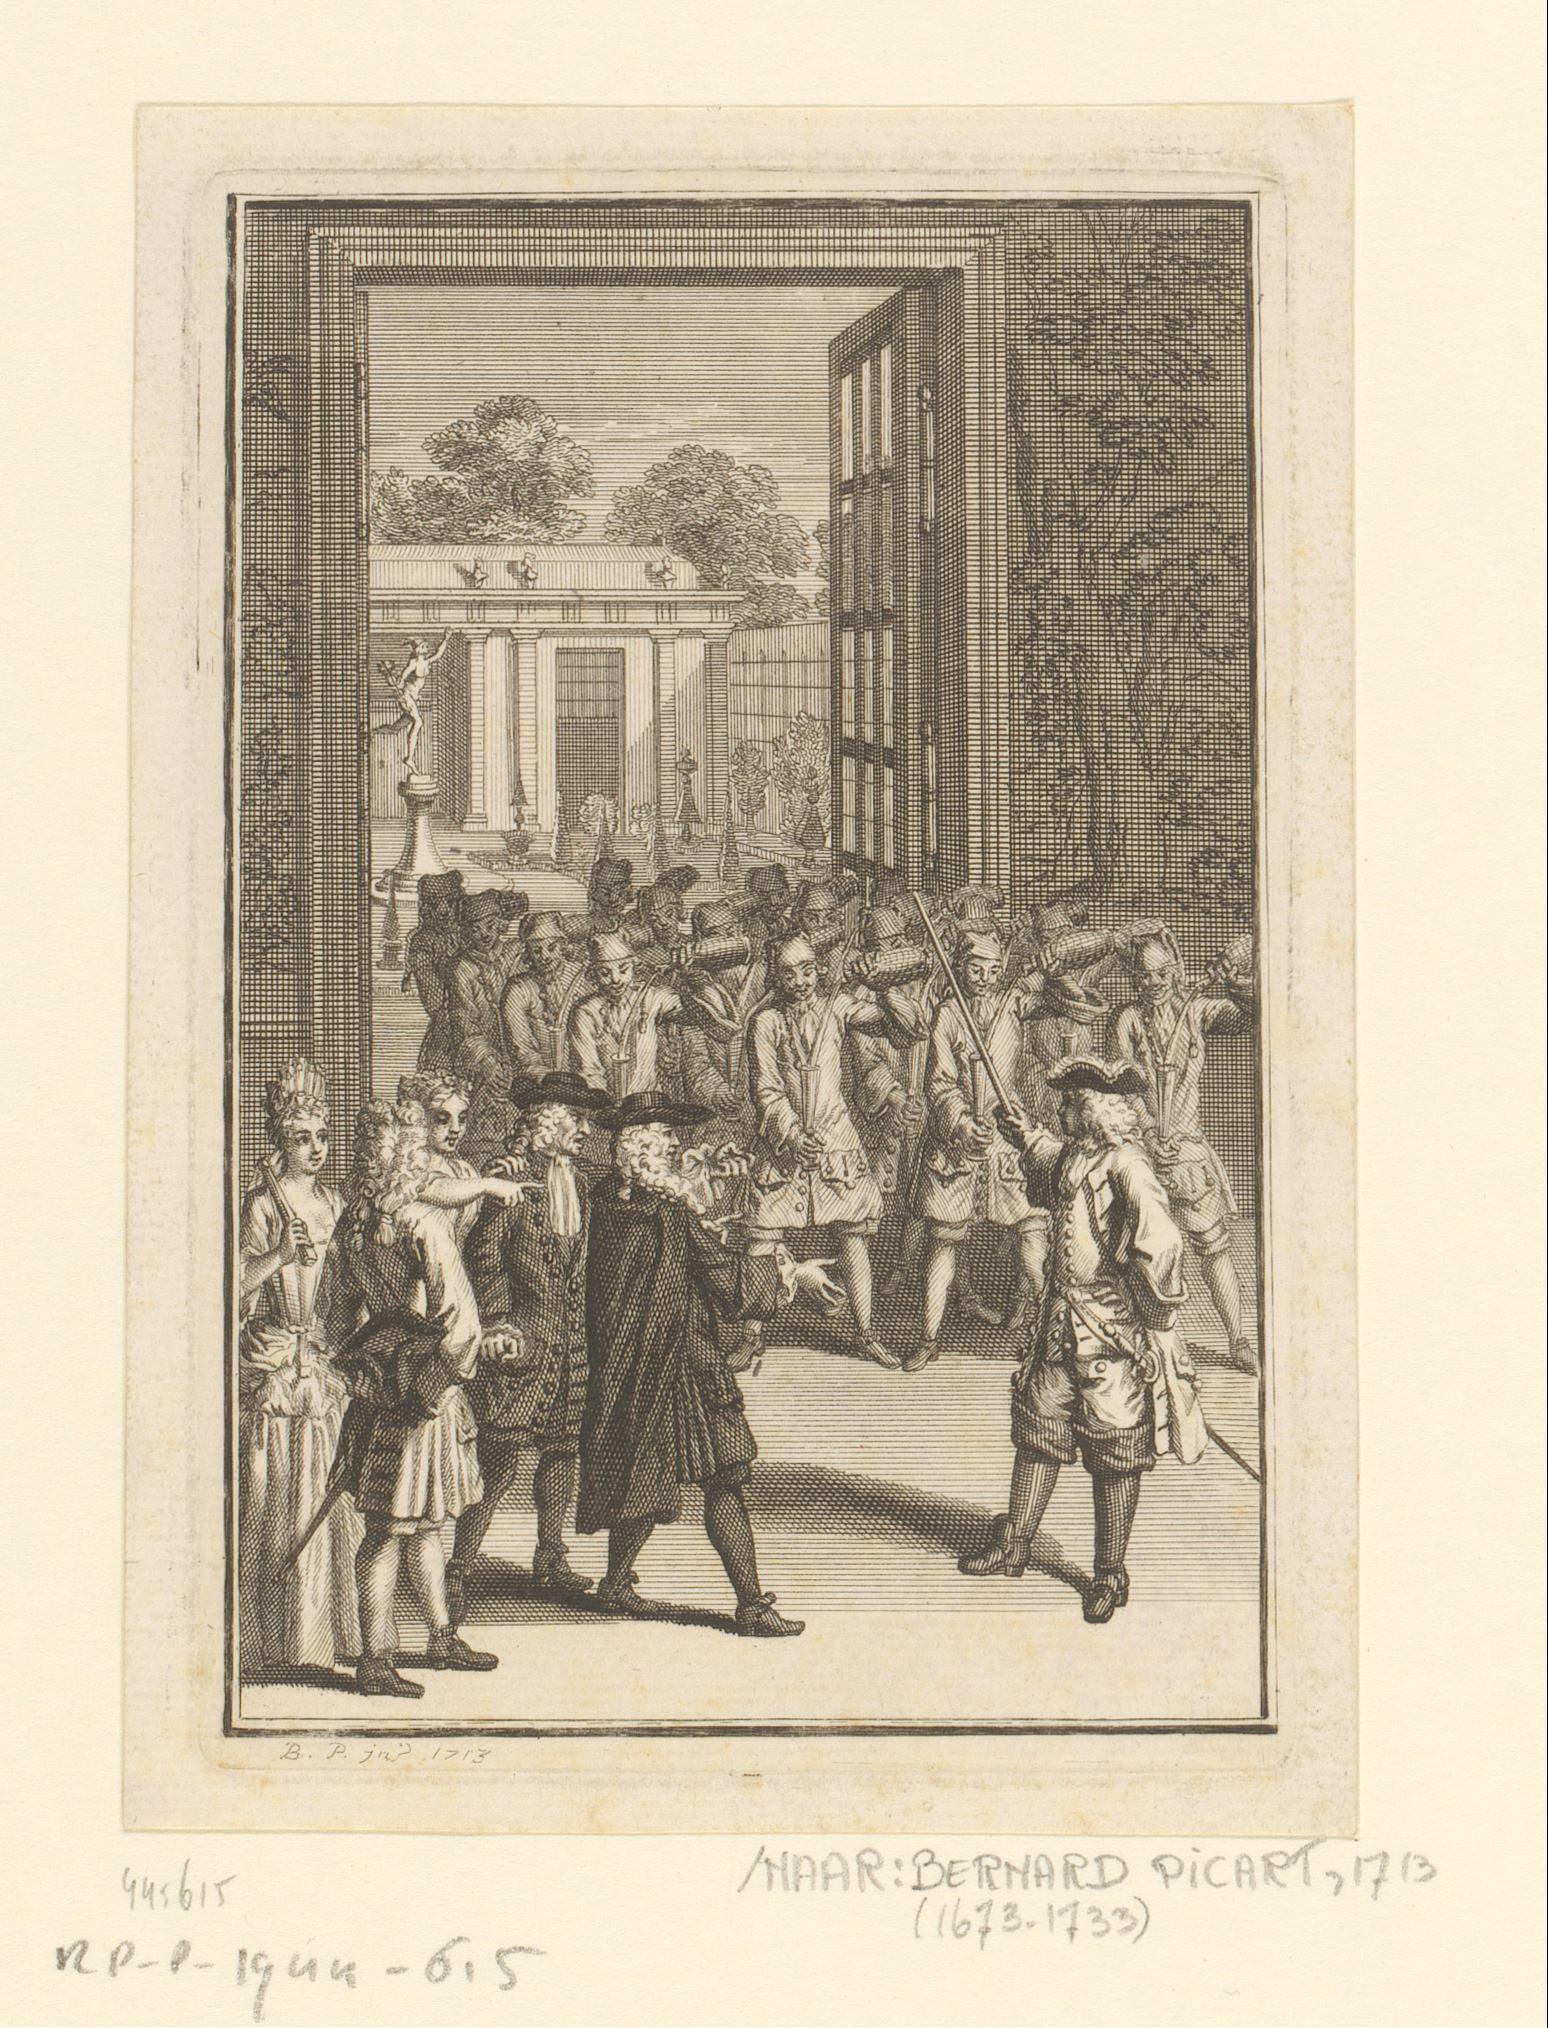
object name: print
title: Ontvangst van een elegant gezelschap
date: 1713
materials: paper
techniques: engraving, etching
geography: amsterdam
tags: pouring, visiting; receiving guests; elegant company, garden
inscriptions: collector's mark: Lugt 2228, collector's mark: Lugt 240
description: Een elegant gezelschap wordt ontvangen in een tuinkamer. Een man wijst met zijn degen op een groep bedienden die drank in glazen schenkt. Op de achtergrond een tuin met een standbeeld van Mercurius.